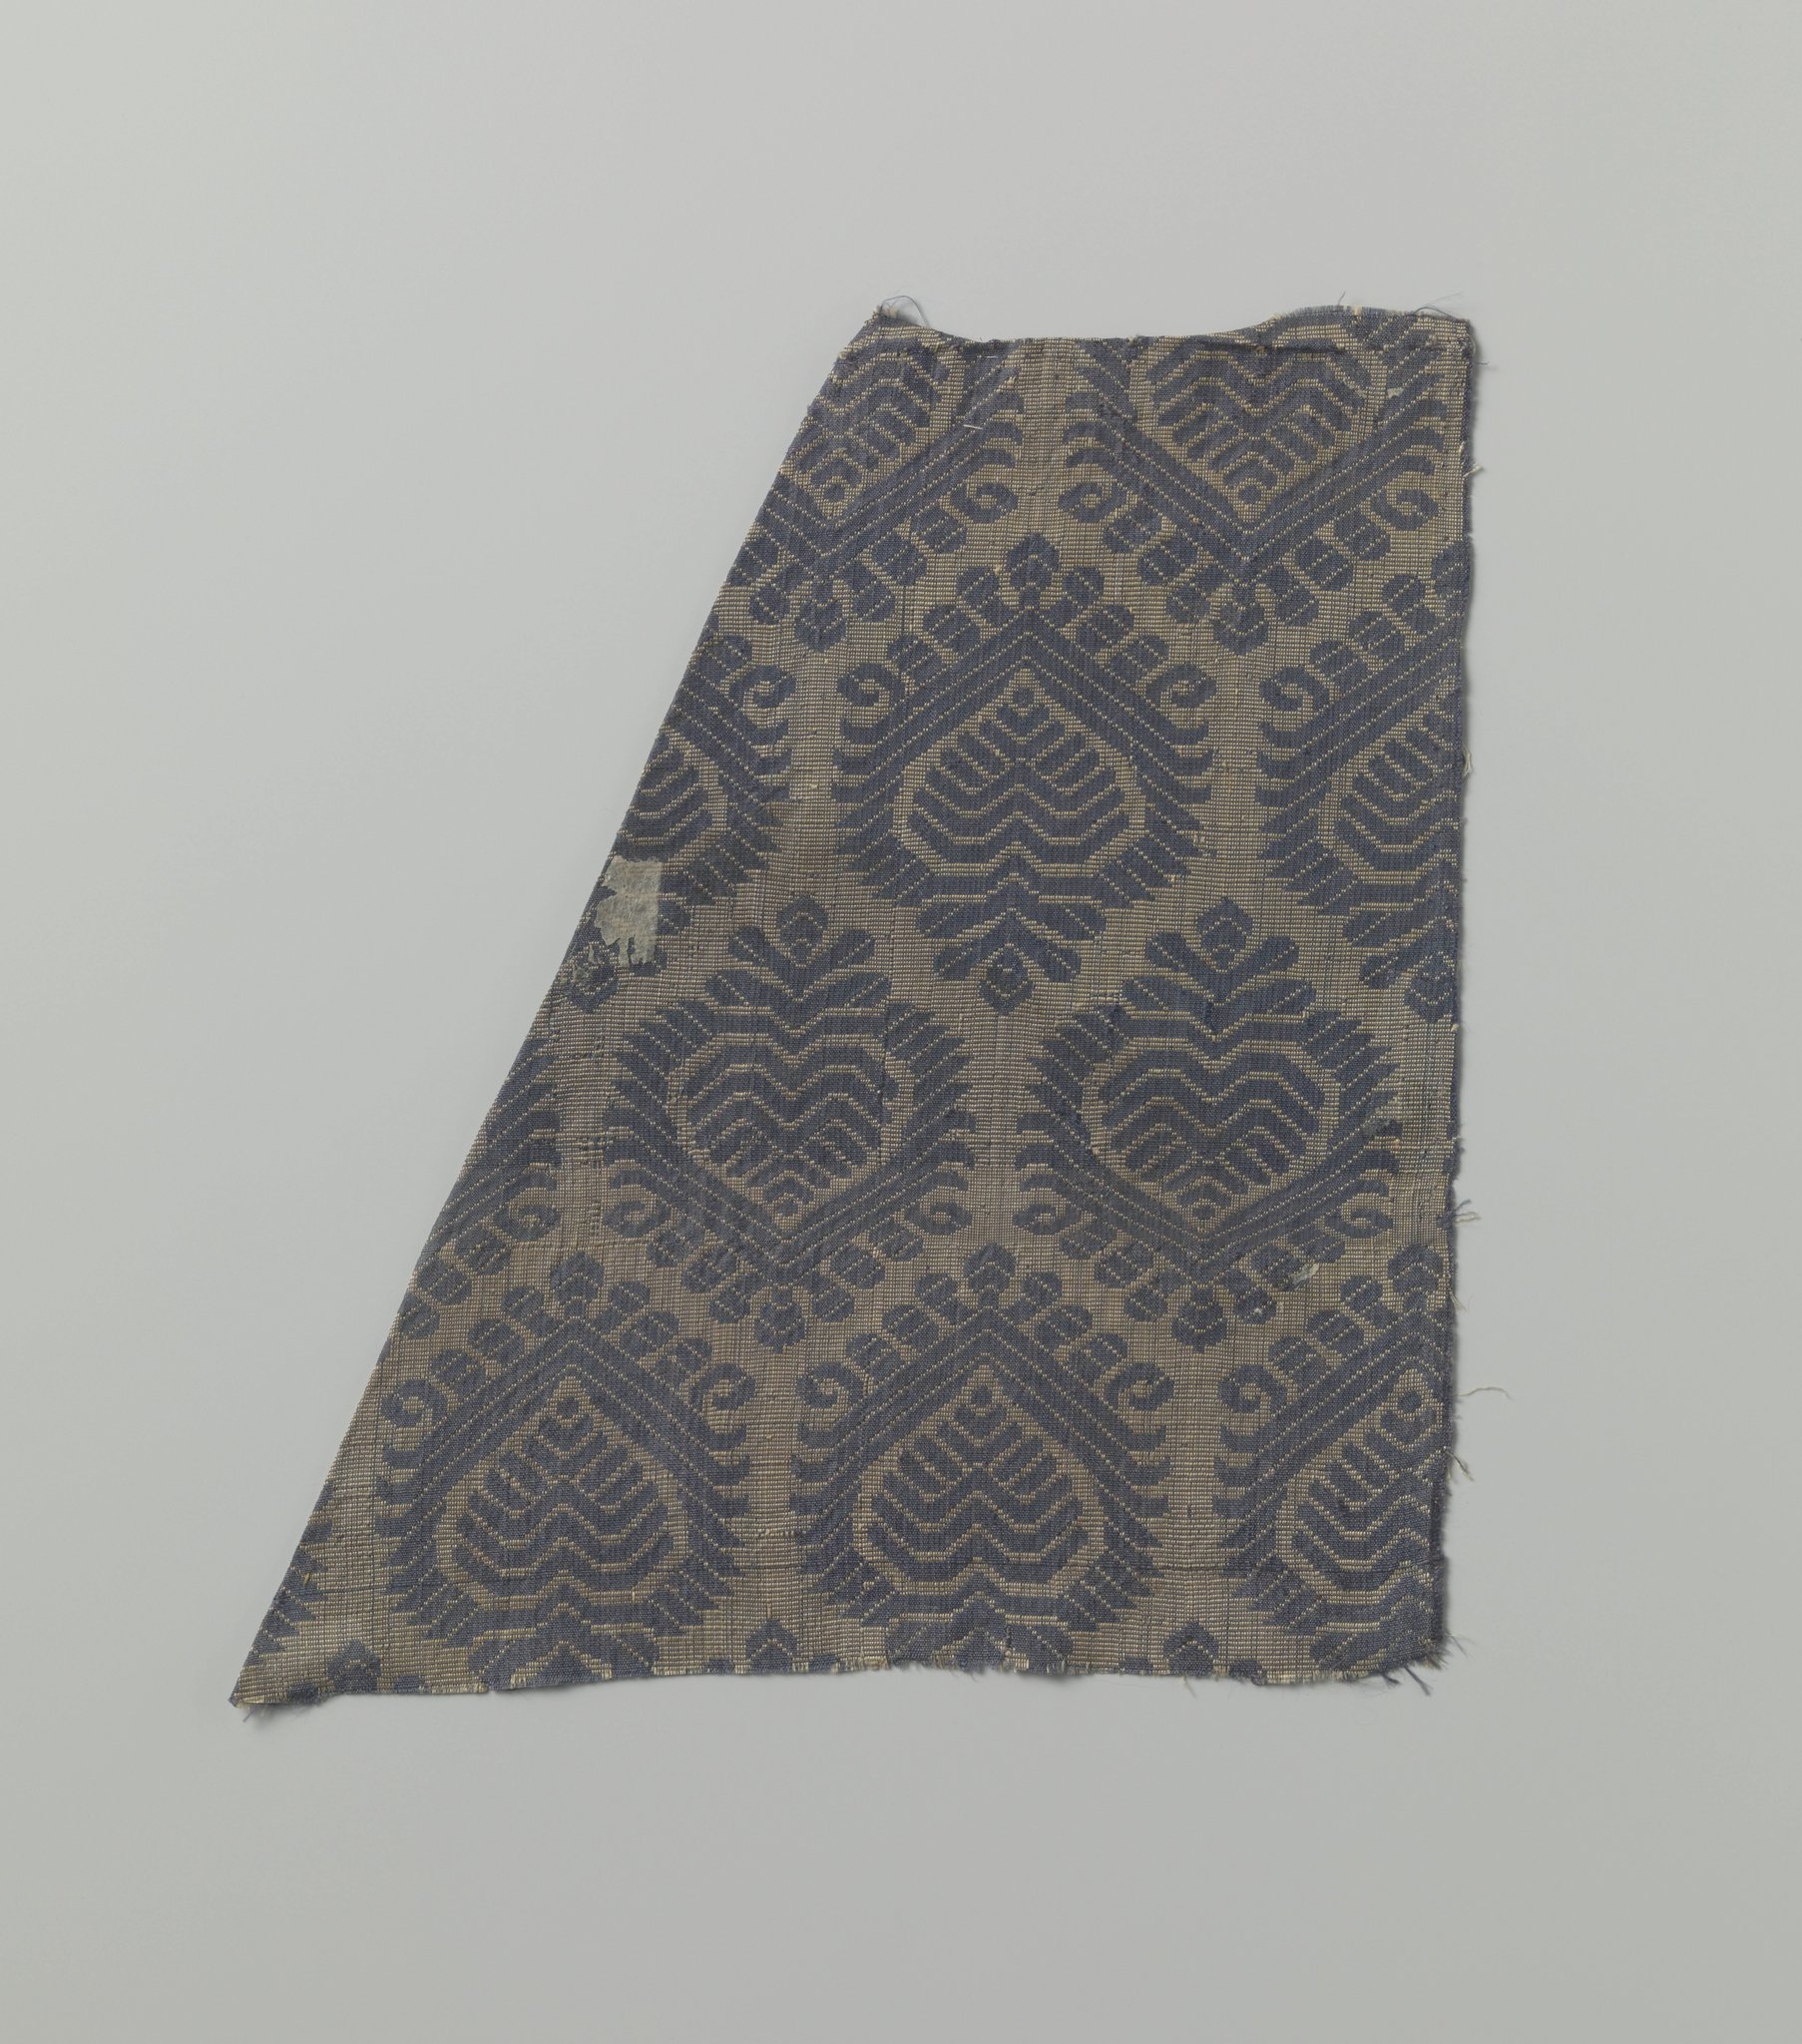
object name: silk textile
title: Fragment geel en blauw zijdeweefsel met palmetmotieven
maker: Anonymous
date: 1500-1599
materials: silk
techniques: weave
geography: italy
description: Fragment gele zijde met patroon in blauw van rijen hartpalmetten die per rij naar boven en naar beneden gericht zijn.